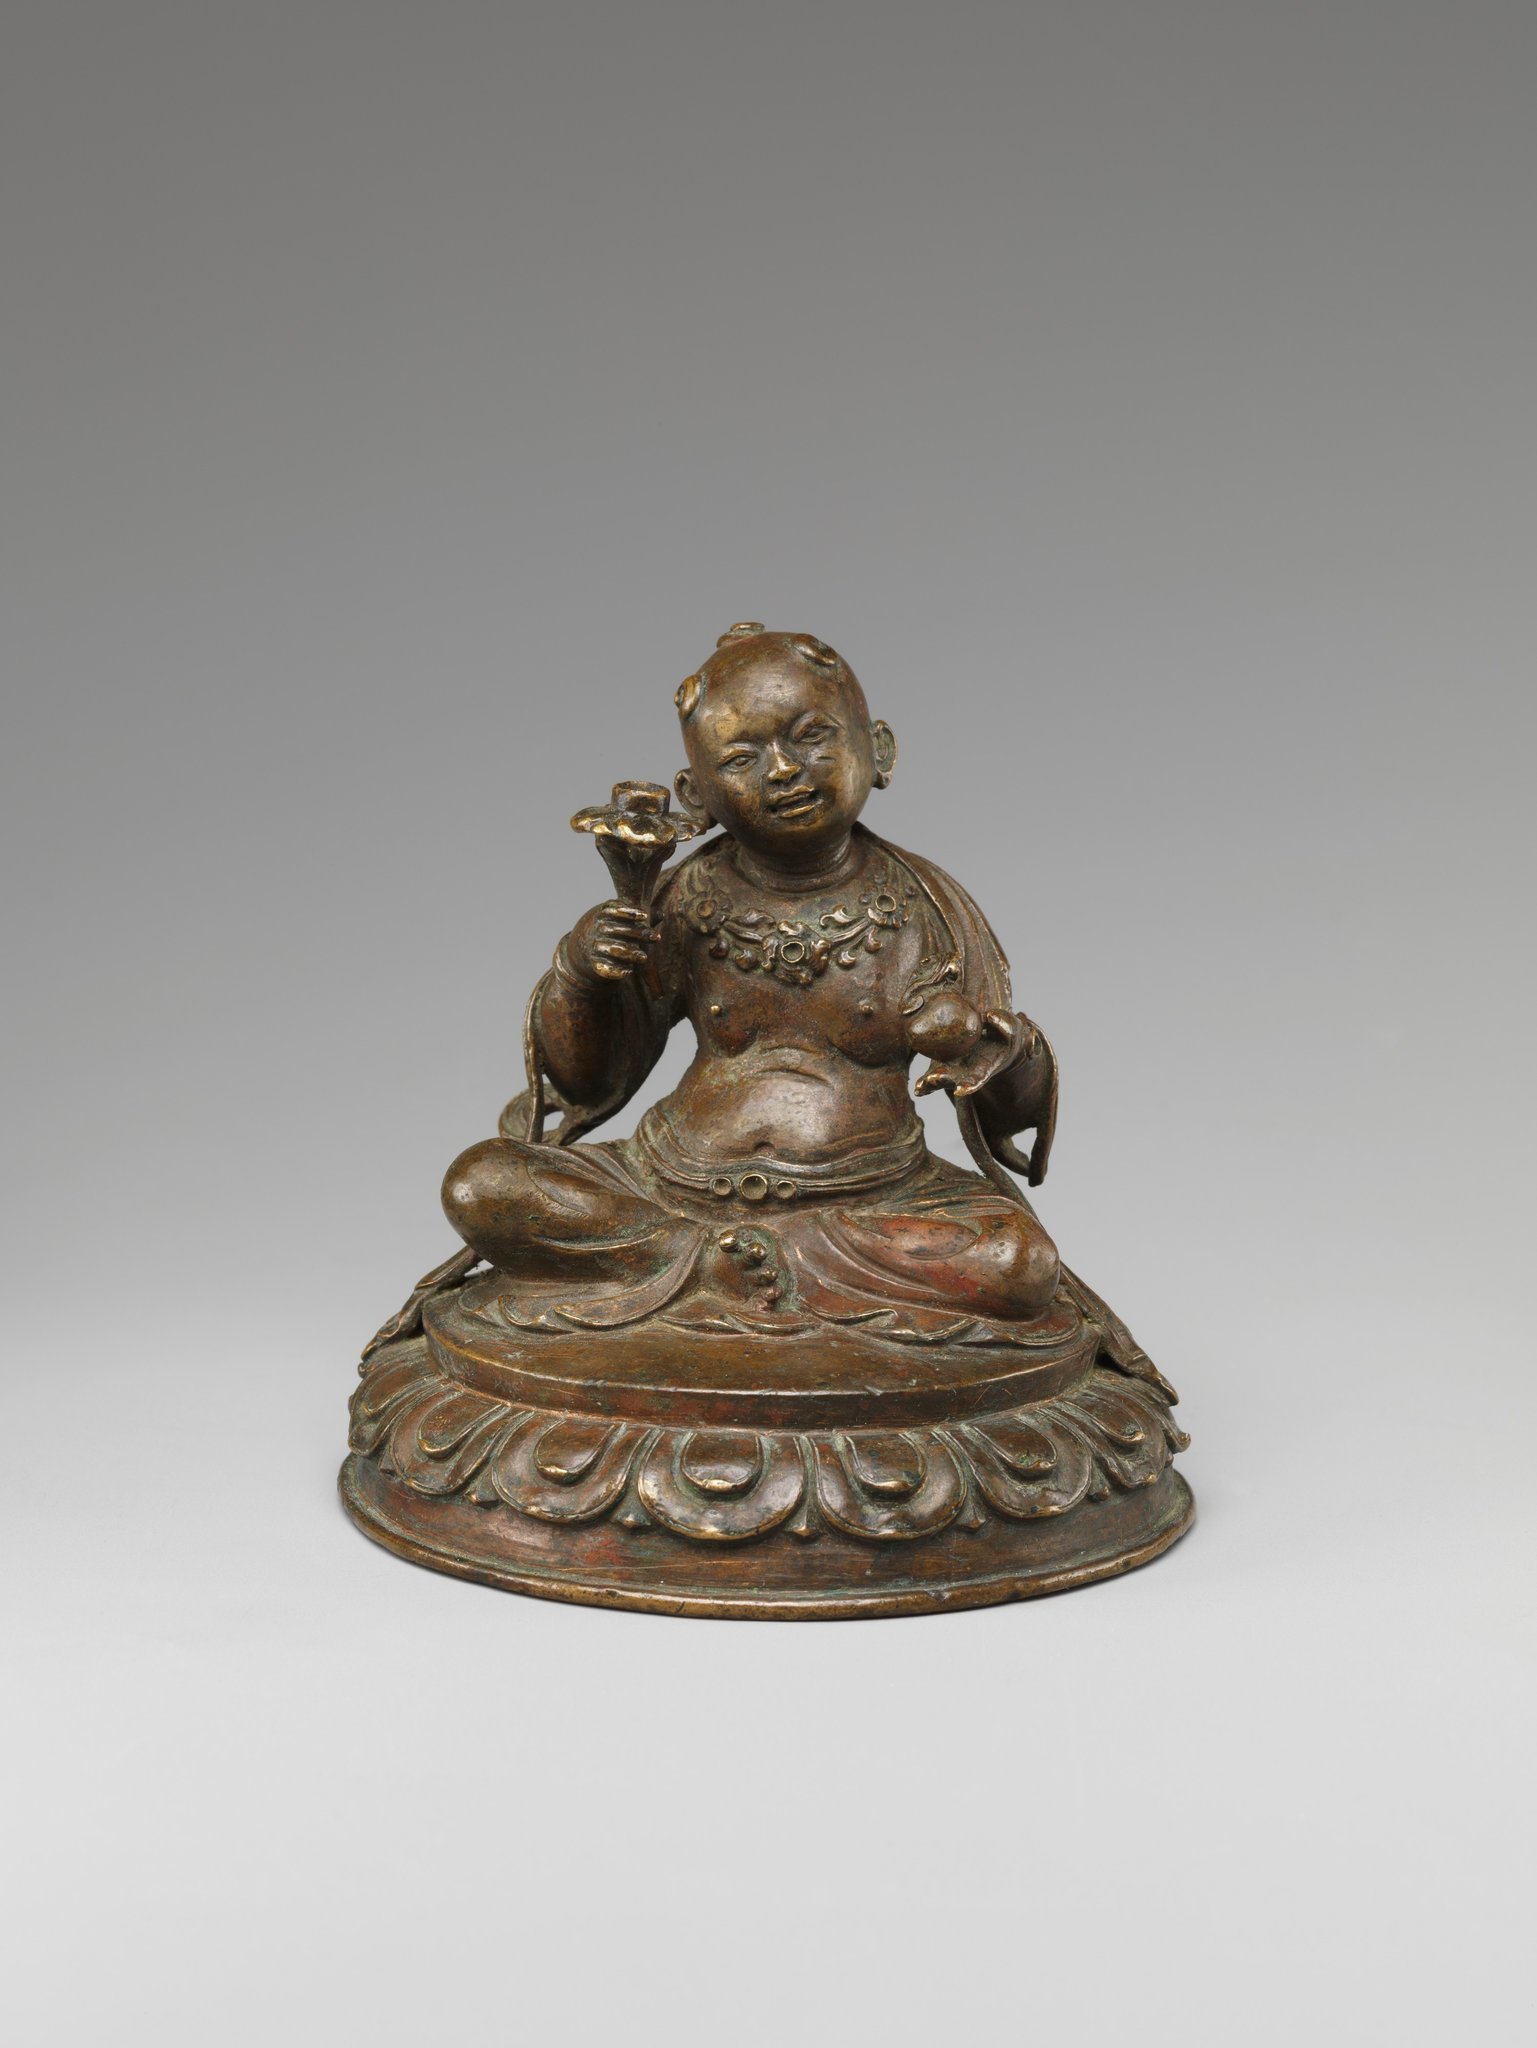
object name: figurine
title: Youthful Manjushri on a Lotus Throne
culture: tibetan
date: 1501-1600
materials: copper alloy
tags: lotuses,manjushri